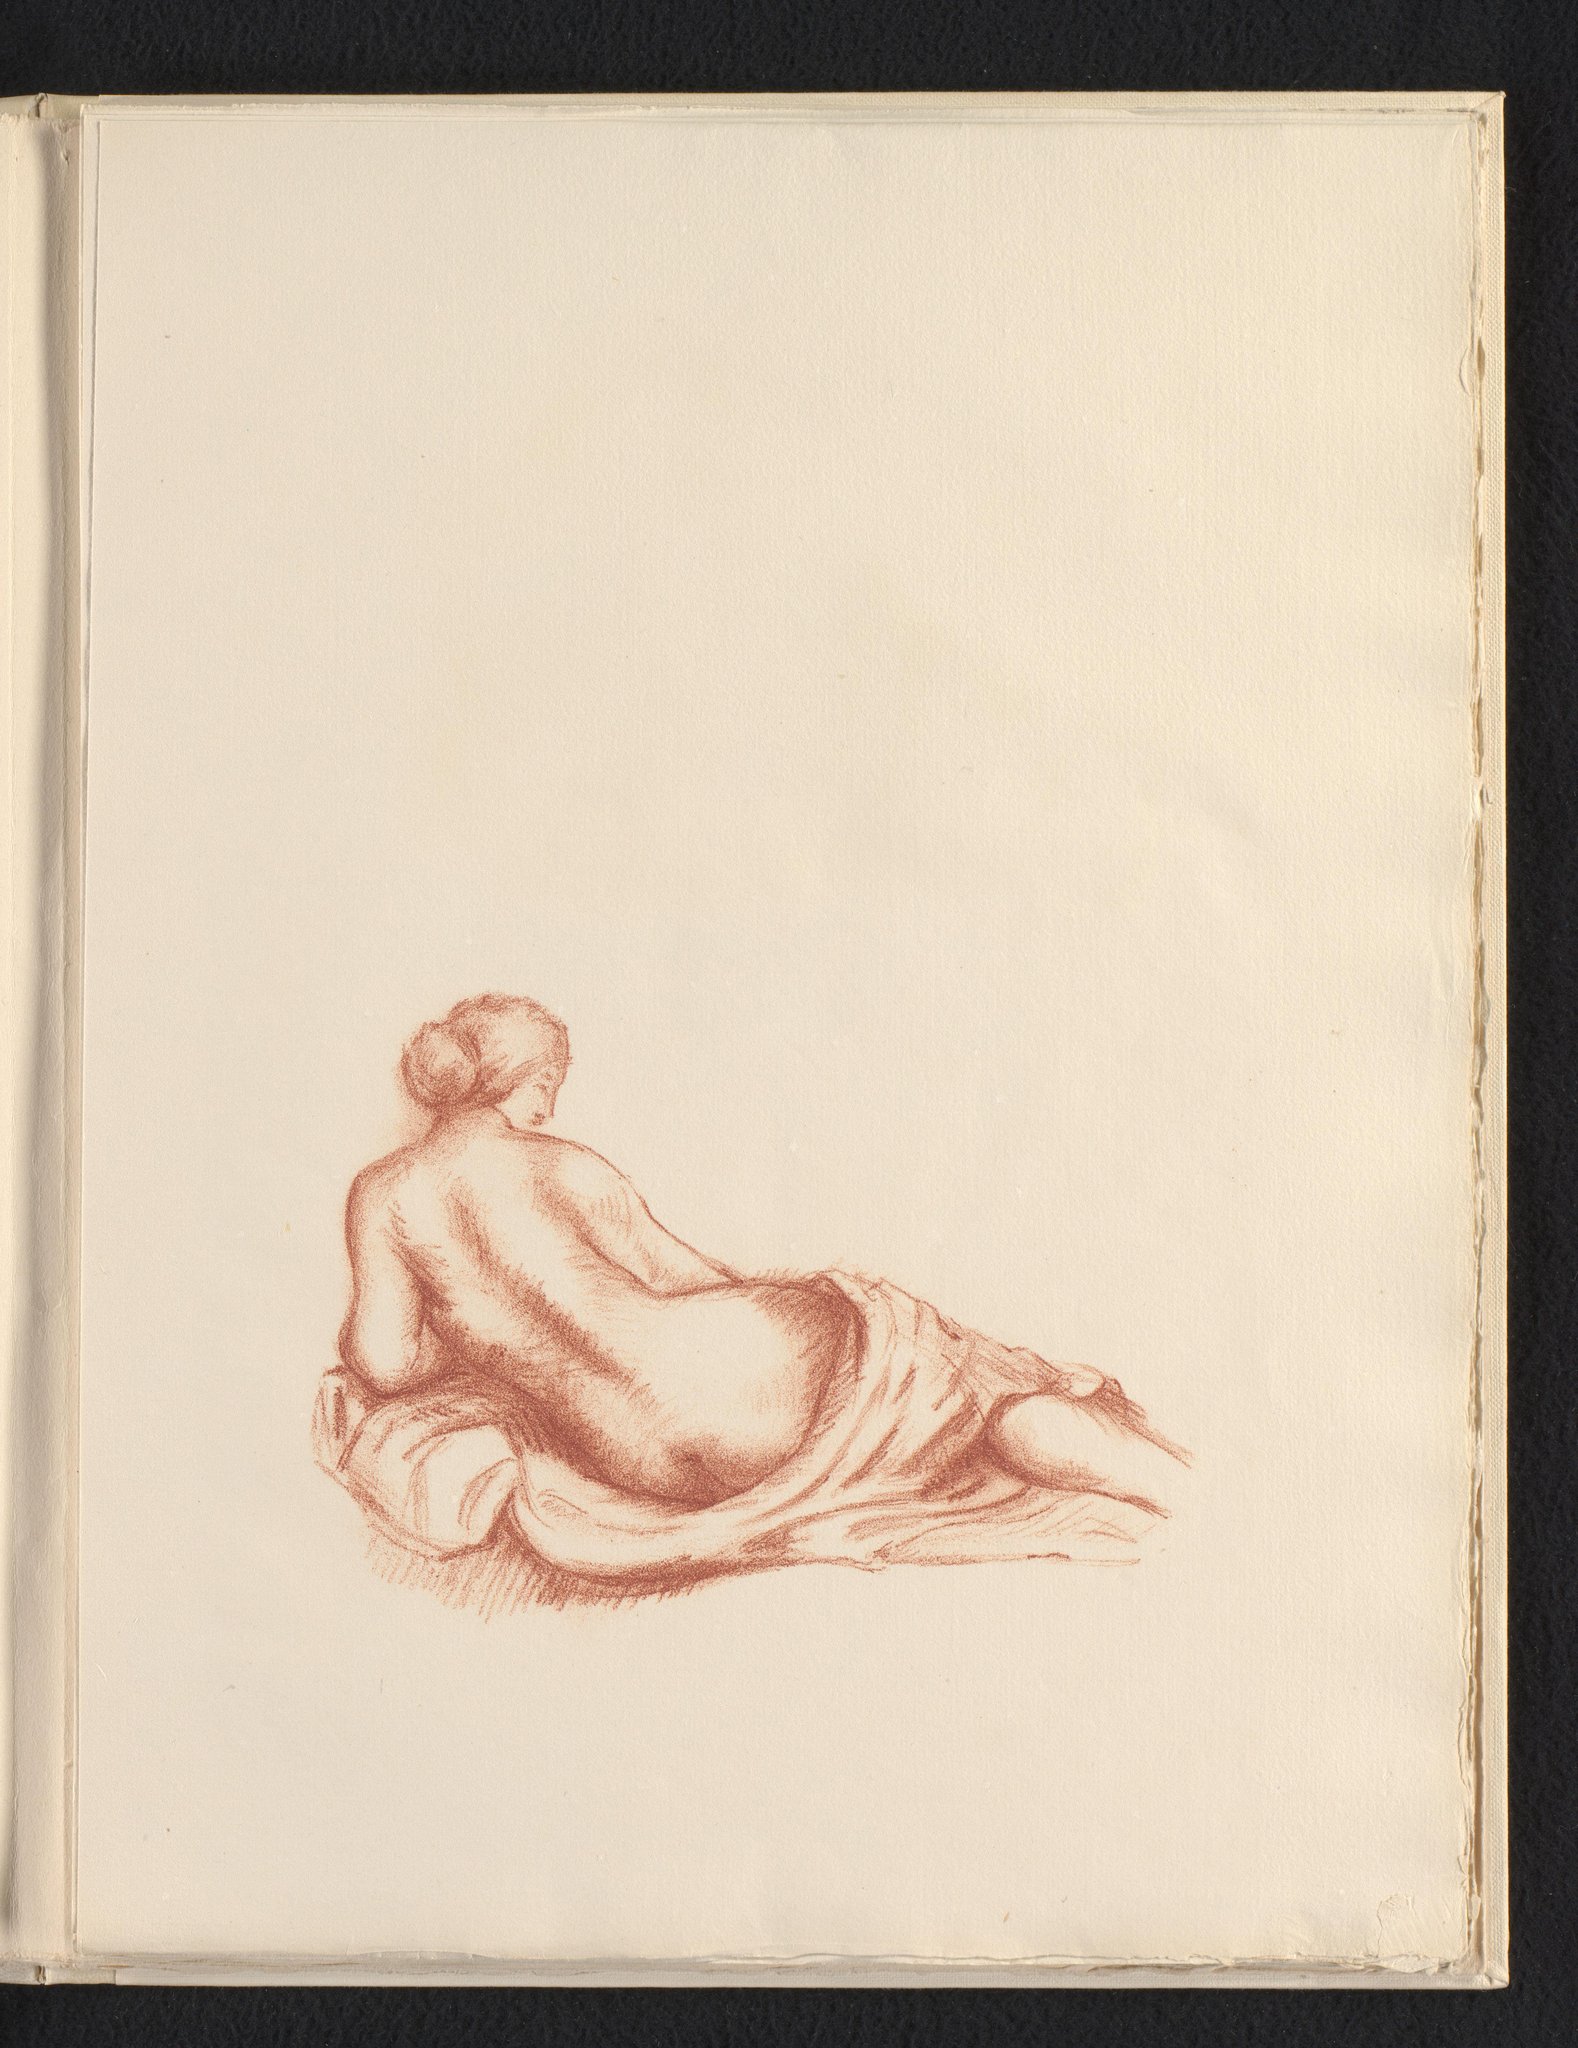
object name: book illustration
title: Liggende naakte vrouw, op de rug gezien, leunend op een arm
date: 1948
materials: paper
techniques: lithograph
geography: paris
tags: lying on one side, with uplifted upper part of the body and leaning on the arm - aa - female human figure, woman (showing herself) undressed, quasi-nude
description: Prent uit: Lucianus van Samosata. Dialogues des Courtisanes. [Vertaald uit het Grieks door] Charles Astruc. Parijs: s.n., 1948, deel van de suite met een extra afdruk van de prenten in sanguine.